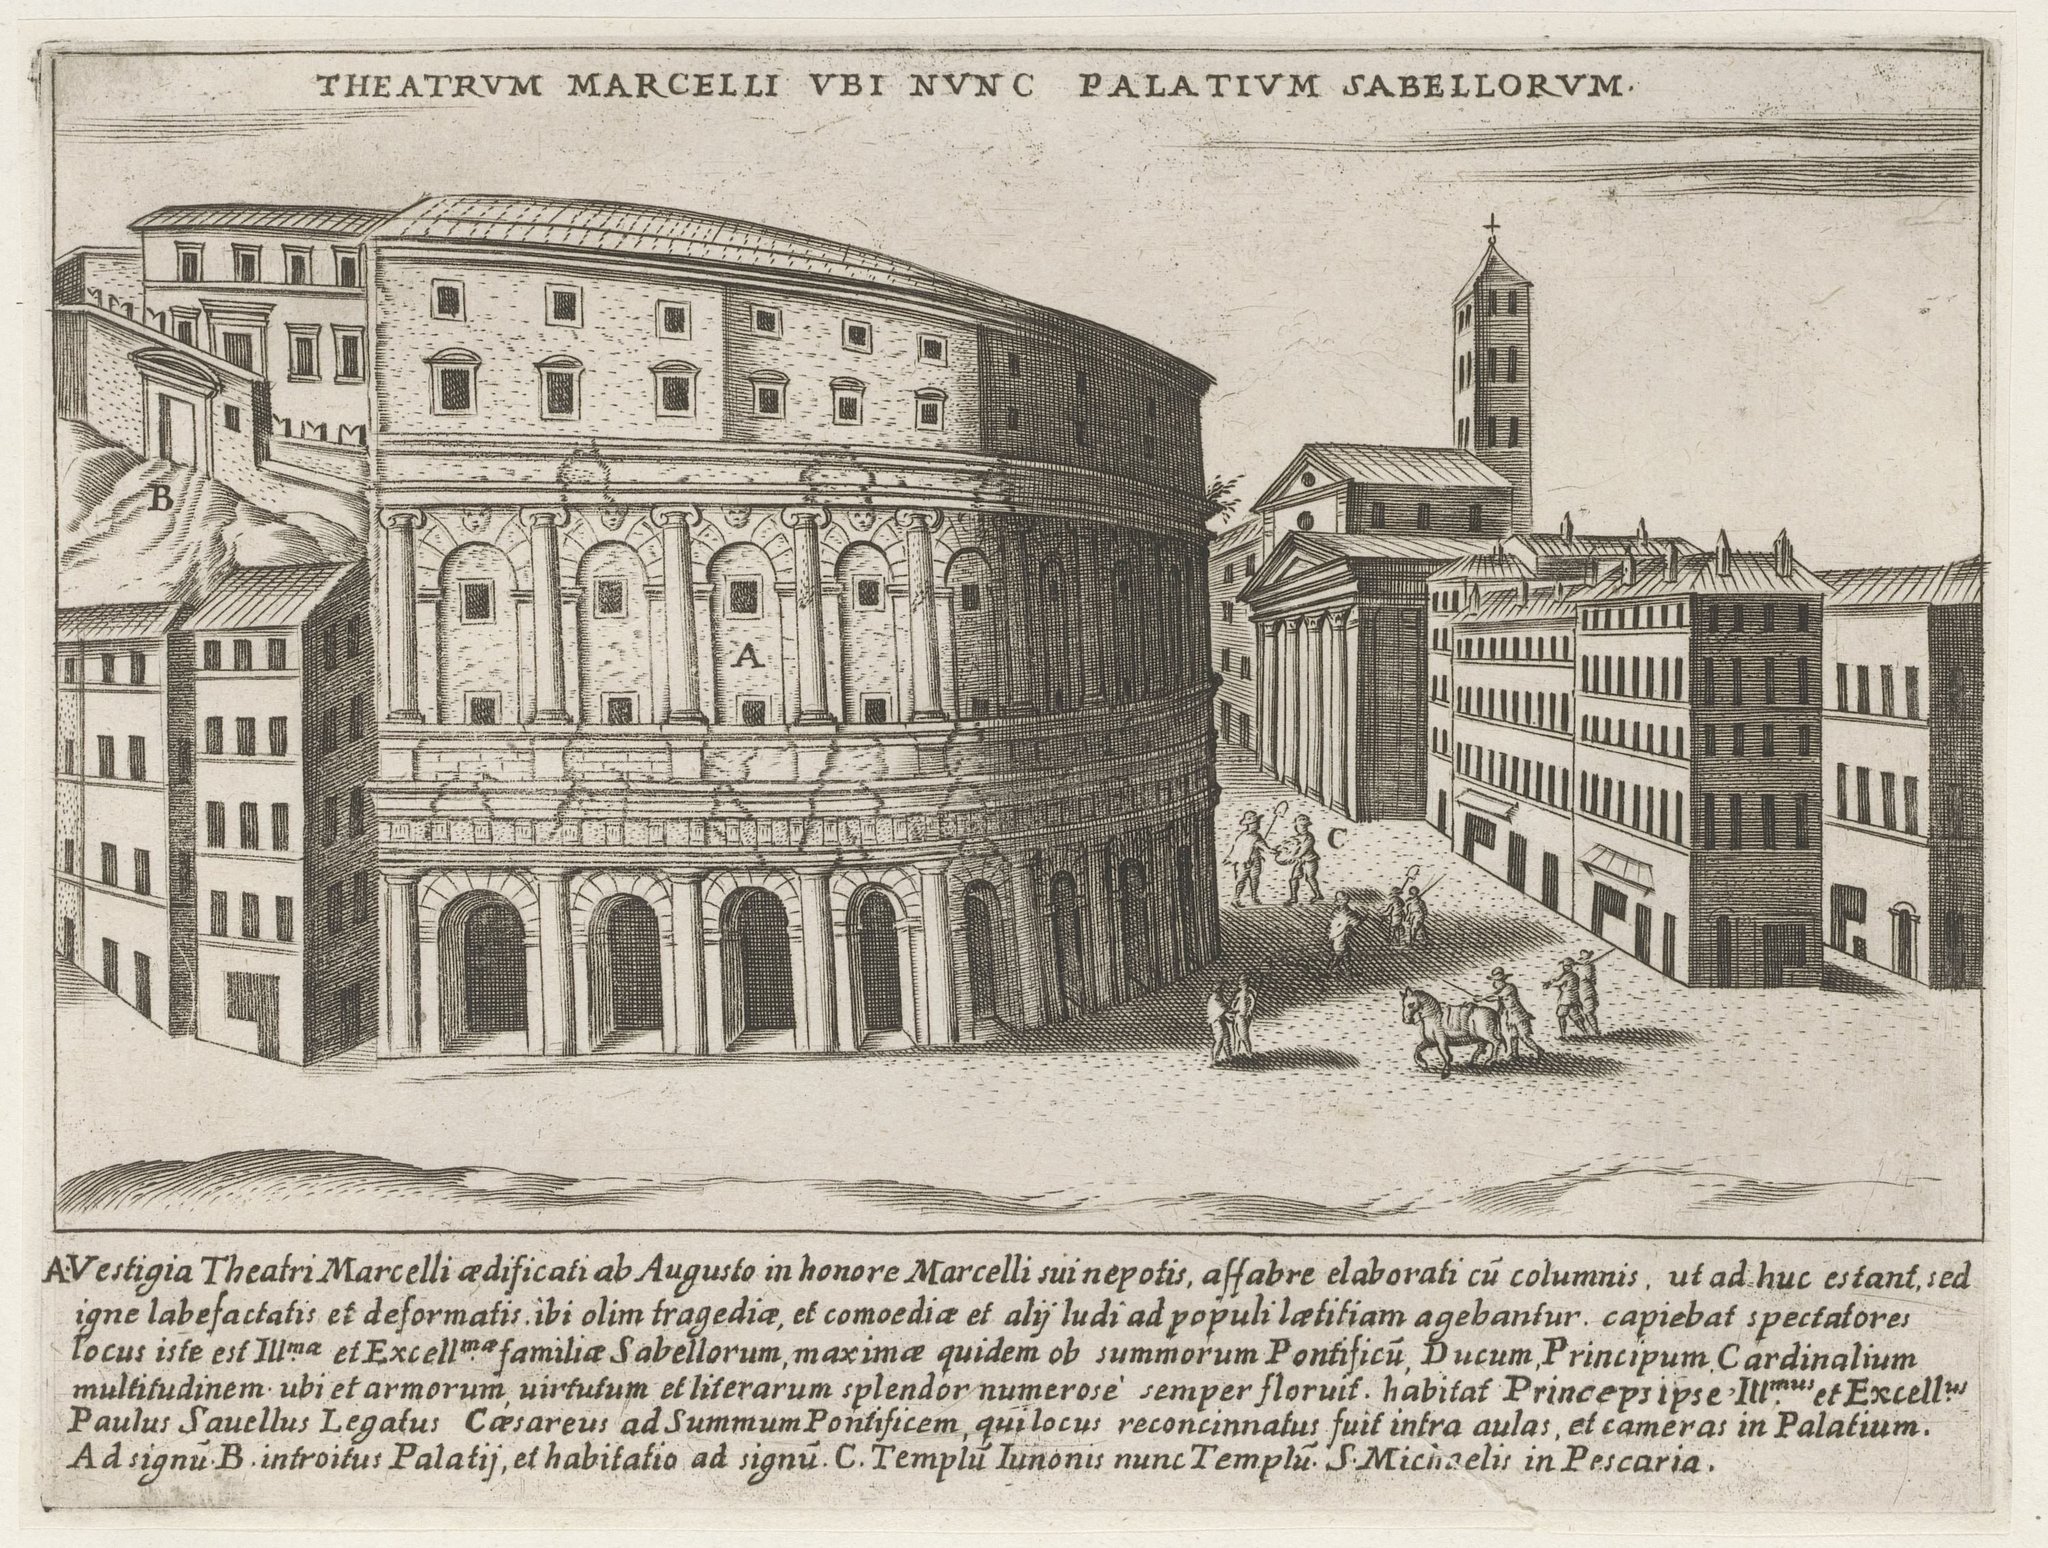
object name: print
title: Magesyn der Italiaense gebouwen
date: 1612-1628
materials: paper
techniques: etching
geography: rome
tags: theatre (building) - aa - open-air performances, representation of real building (either existing or having existed)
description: Deze prent maakt deel uit van een set van 158 prenten (+ titelprenten), die verscheen in vier delen. In 1612 verschenen delen één en twee. In 1615 verscheen het derde deel en in 1628 verscheen deel vier. In 1637 publiceerde Vitale Mascardi de eerste heruitgave van de gehele set met nummering.